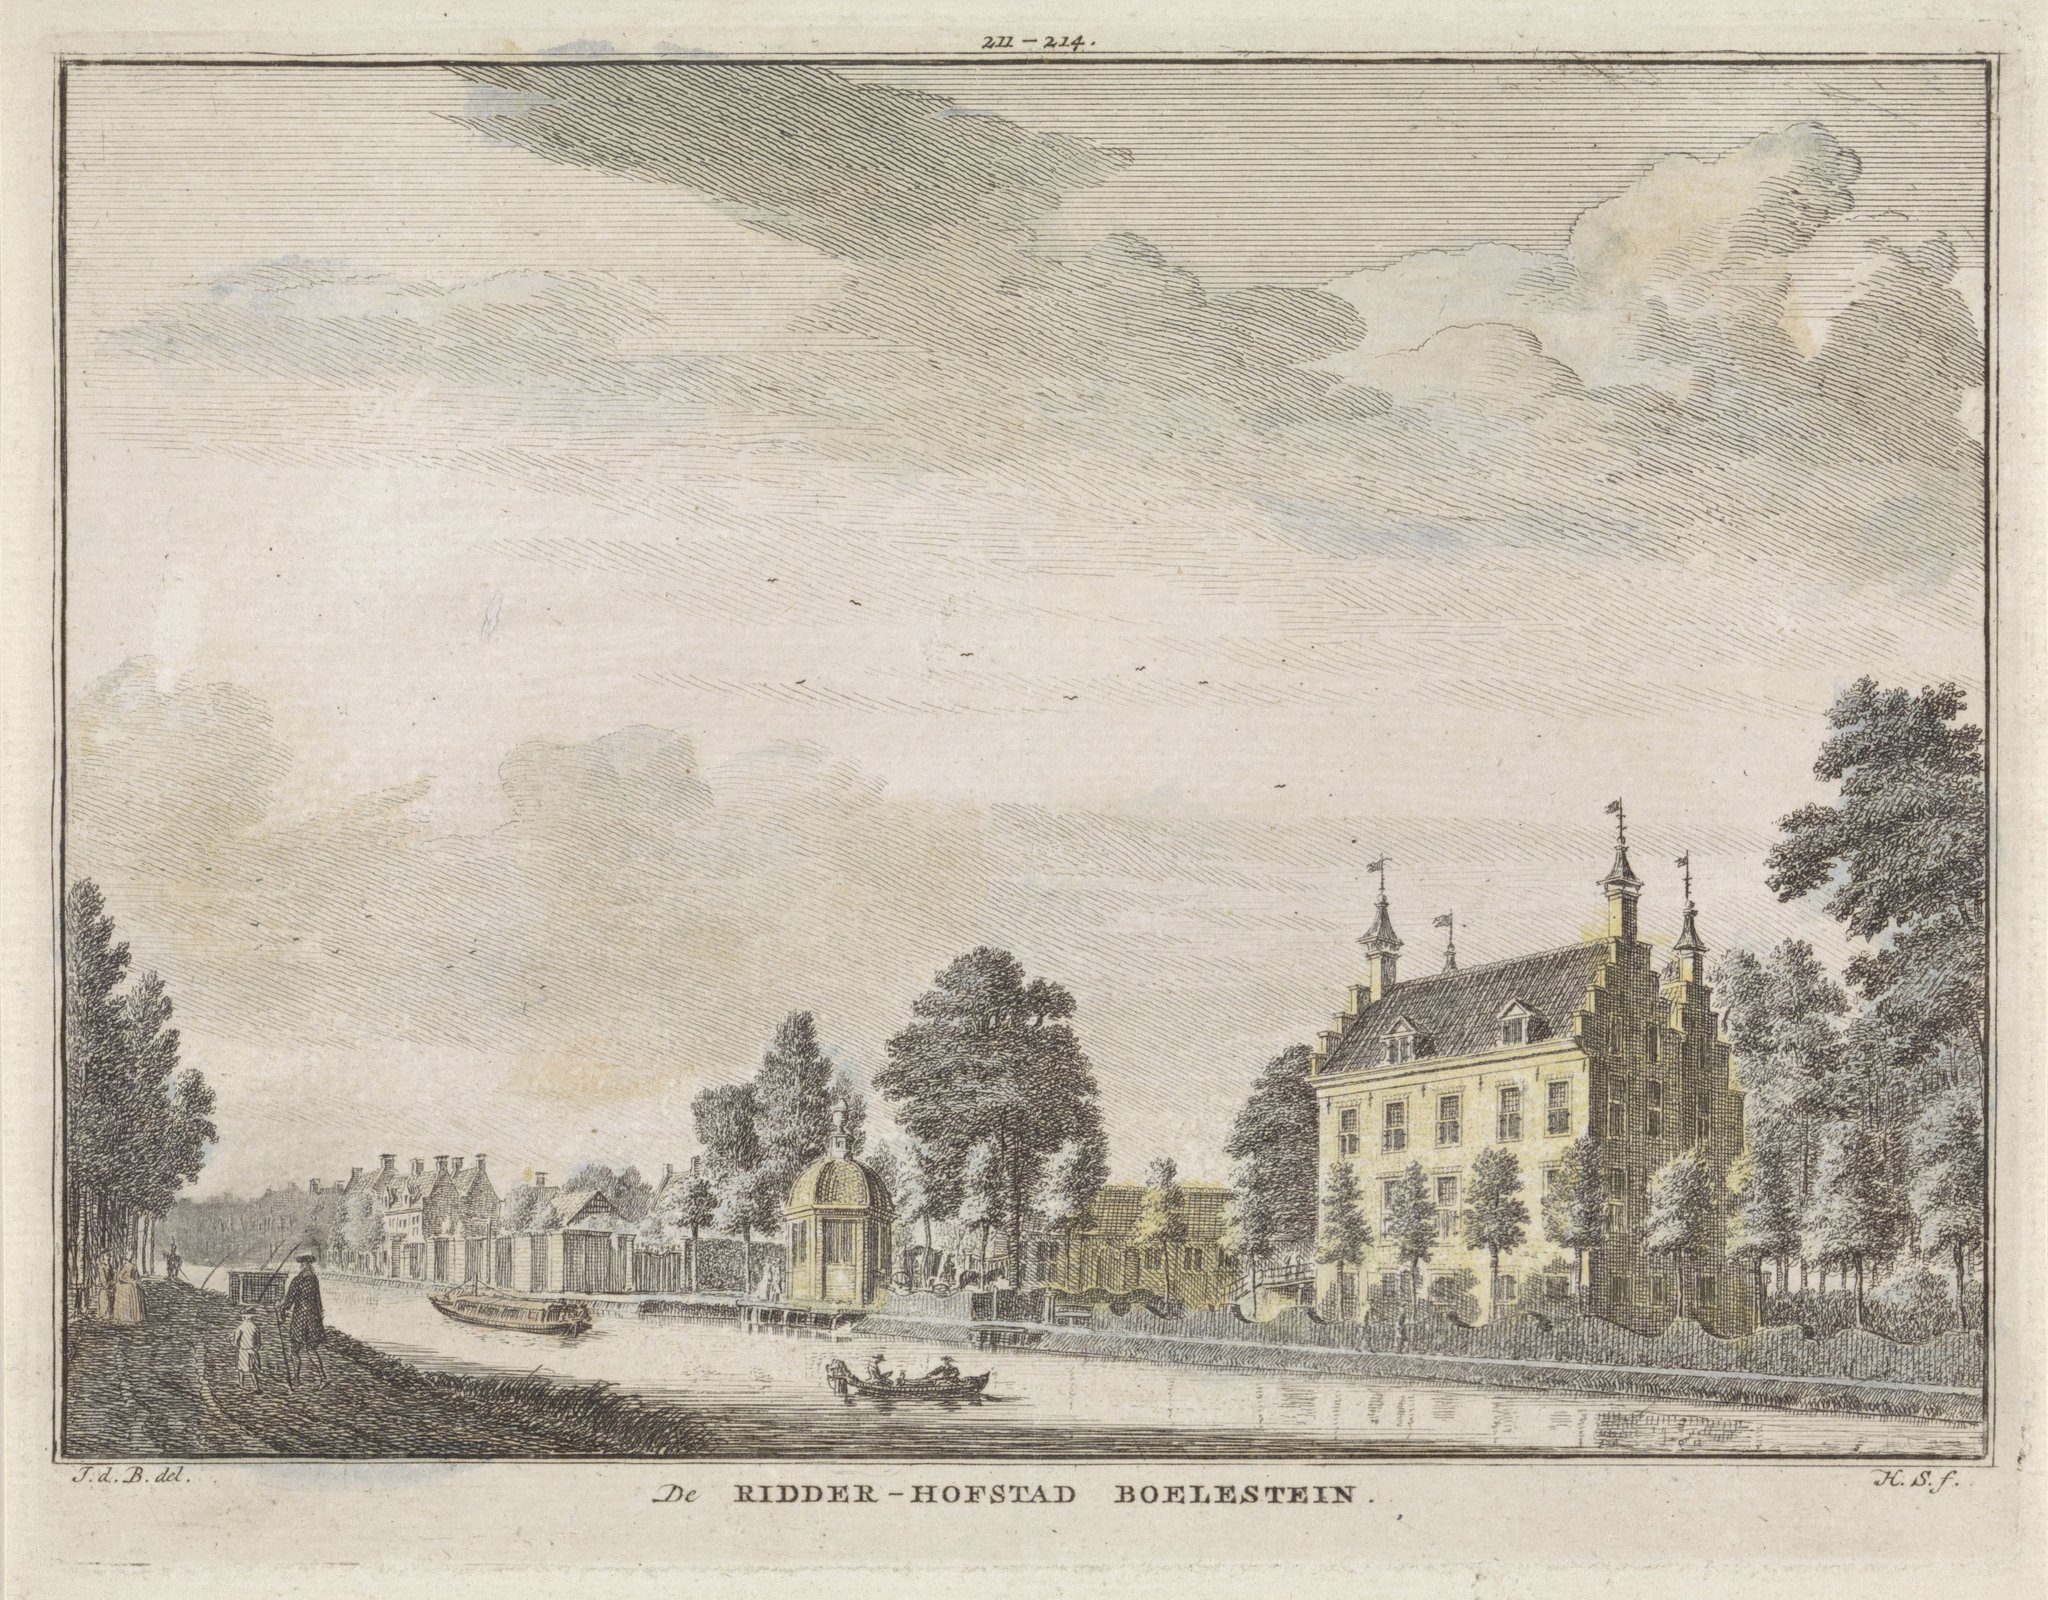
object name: book illustration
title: Gezicht op kasteel Boelenstein, Maarssen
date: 1774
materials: paper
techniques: etching, hand coloring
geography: haarlem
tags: castle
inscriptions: collector's mark: Lugt 2228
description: Prent gebruikt in: Het verheerlykt Nederland of kabinet van hedendaagsche gezigten van steden, dorpen, sloten ... en andere voornaame stad- en landgebouwen, in en omtrent alle de byzondere Vereenigde Nederlandsche Provinciën : gedurende de laatste jaaren door vermaarden kunsttekenaren na het leven getekent en ... in 't koper gebragt ... dienende tot opheldering der beschryvinge van den Tegenwoordigen Staat der Vereenigde Nederlanden. Deel IX, 1774. Amsterdam: Isaac Tirion, 1745-1774.